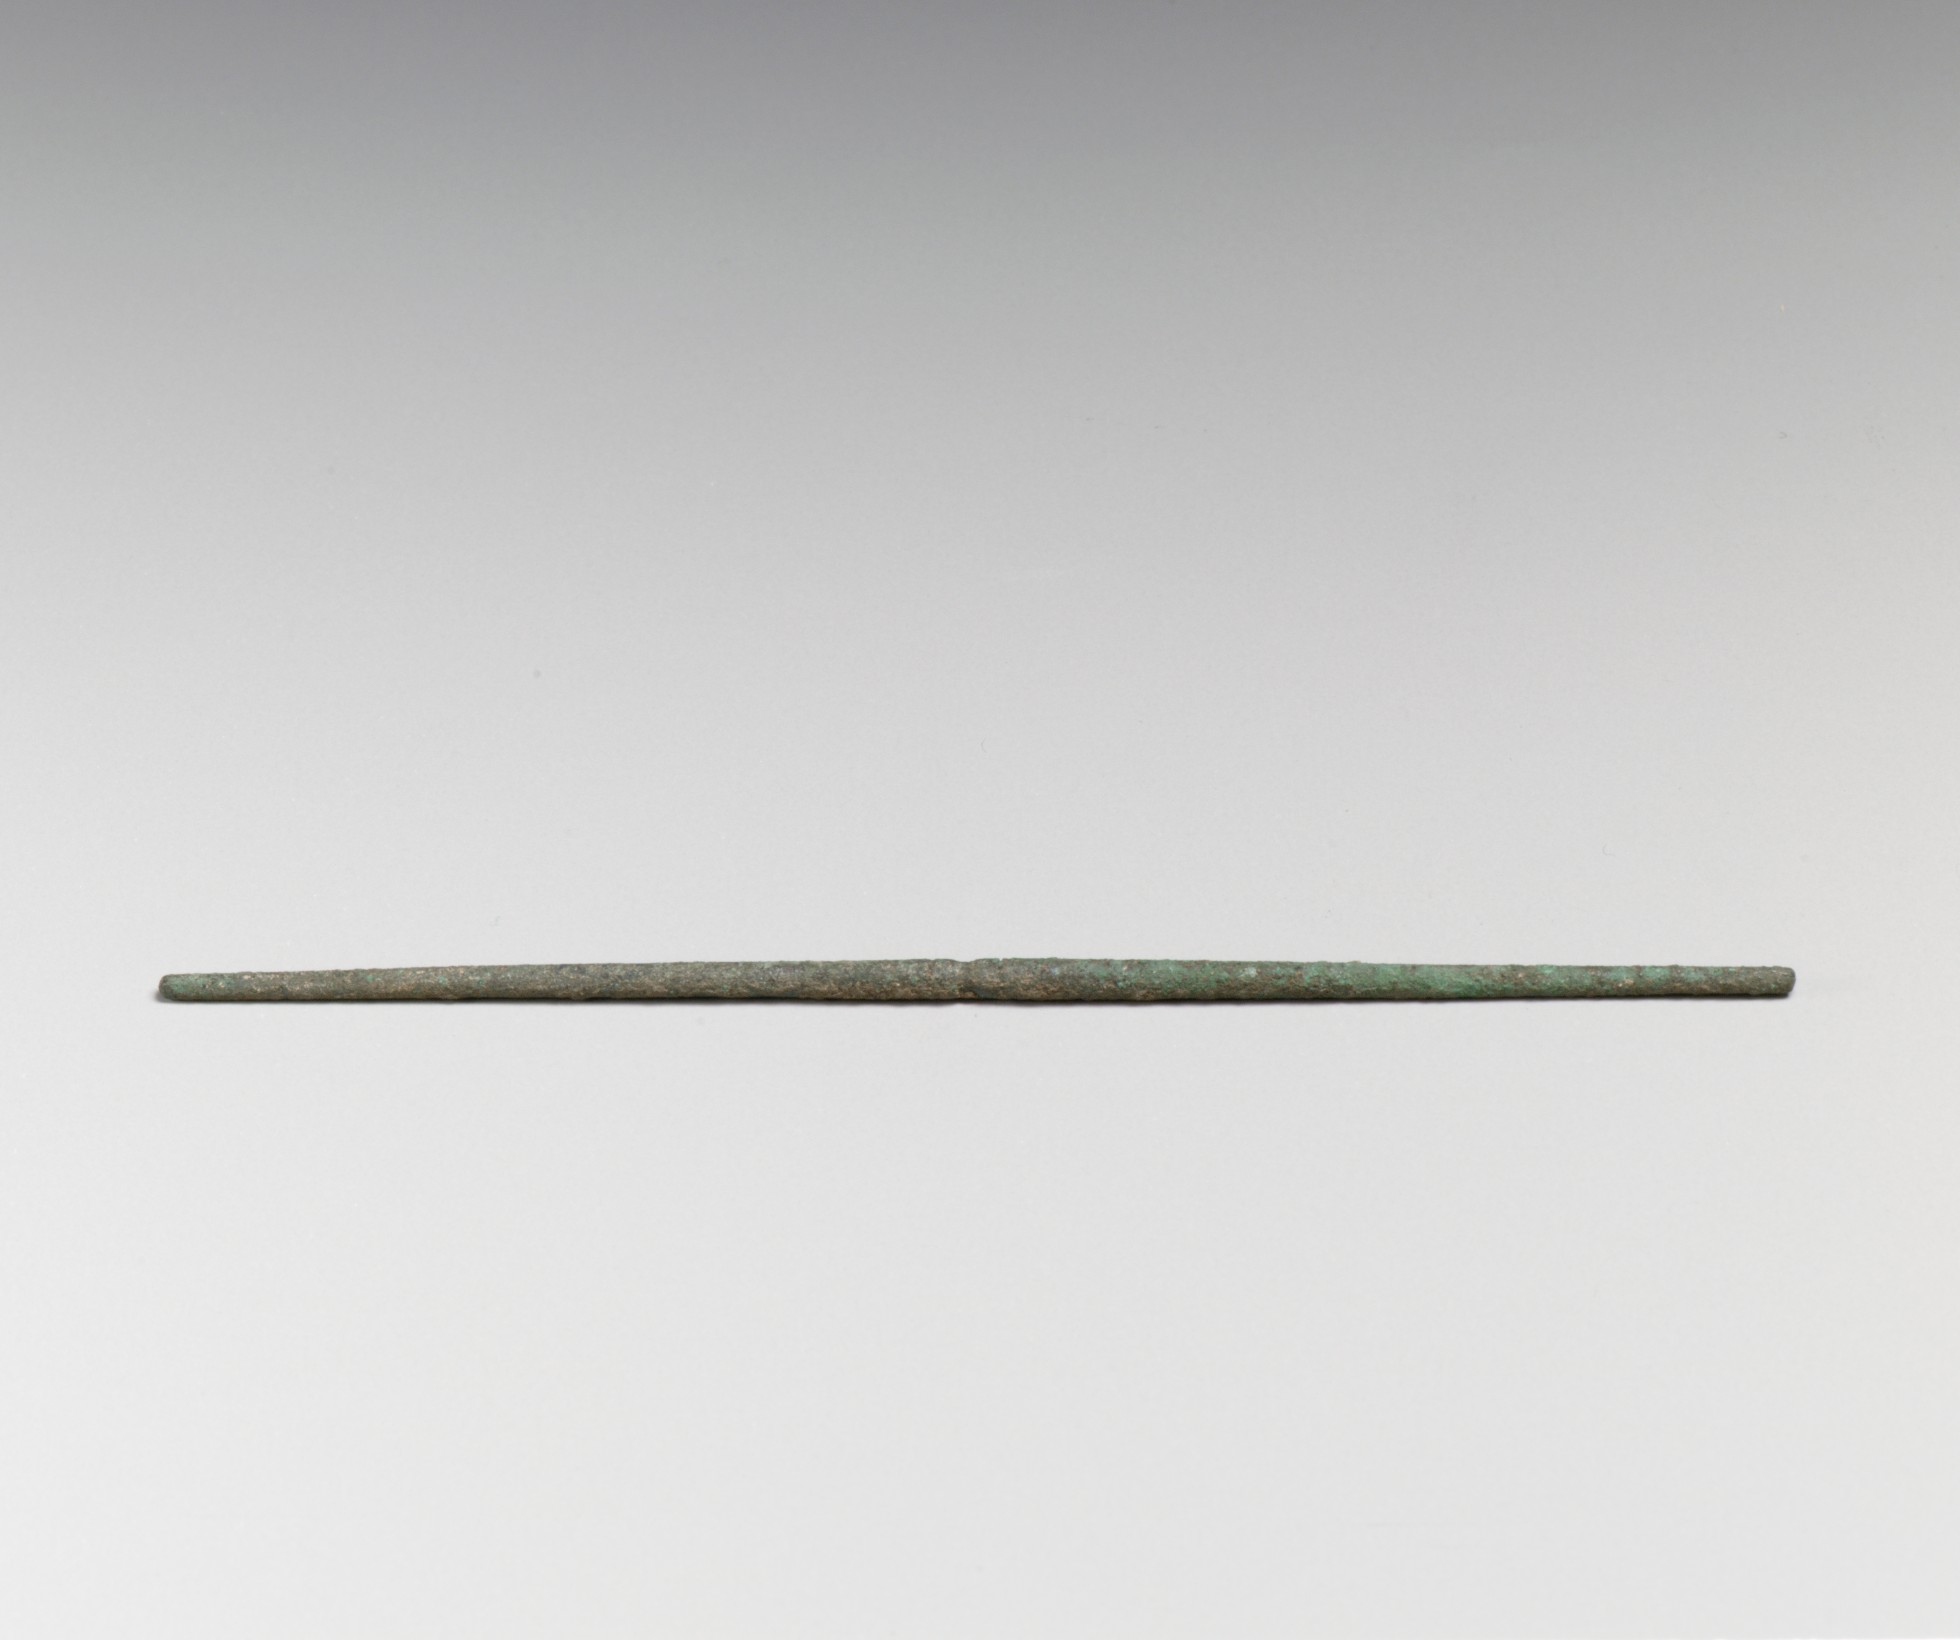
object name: probe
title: Probe ?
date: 7000 BCE-330 CE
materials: bronze